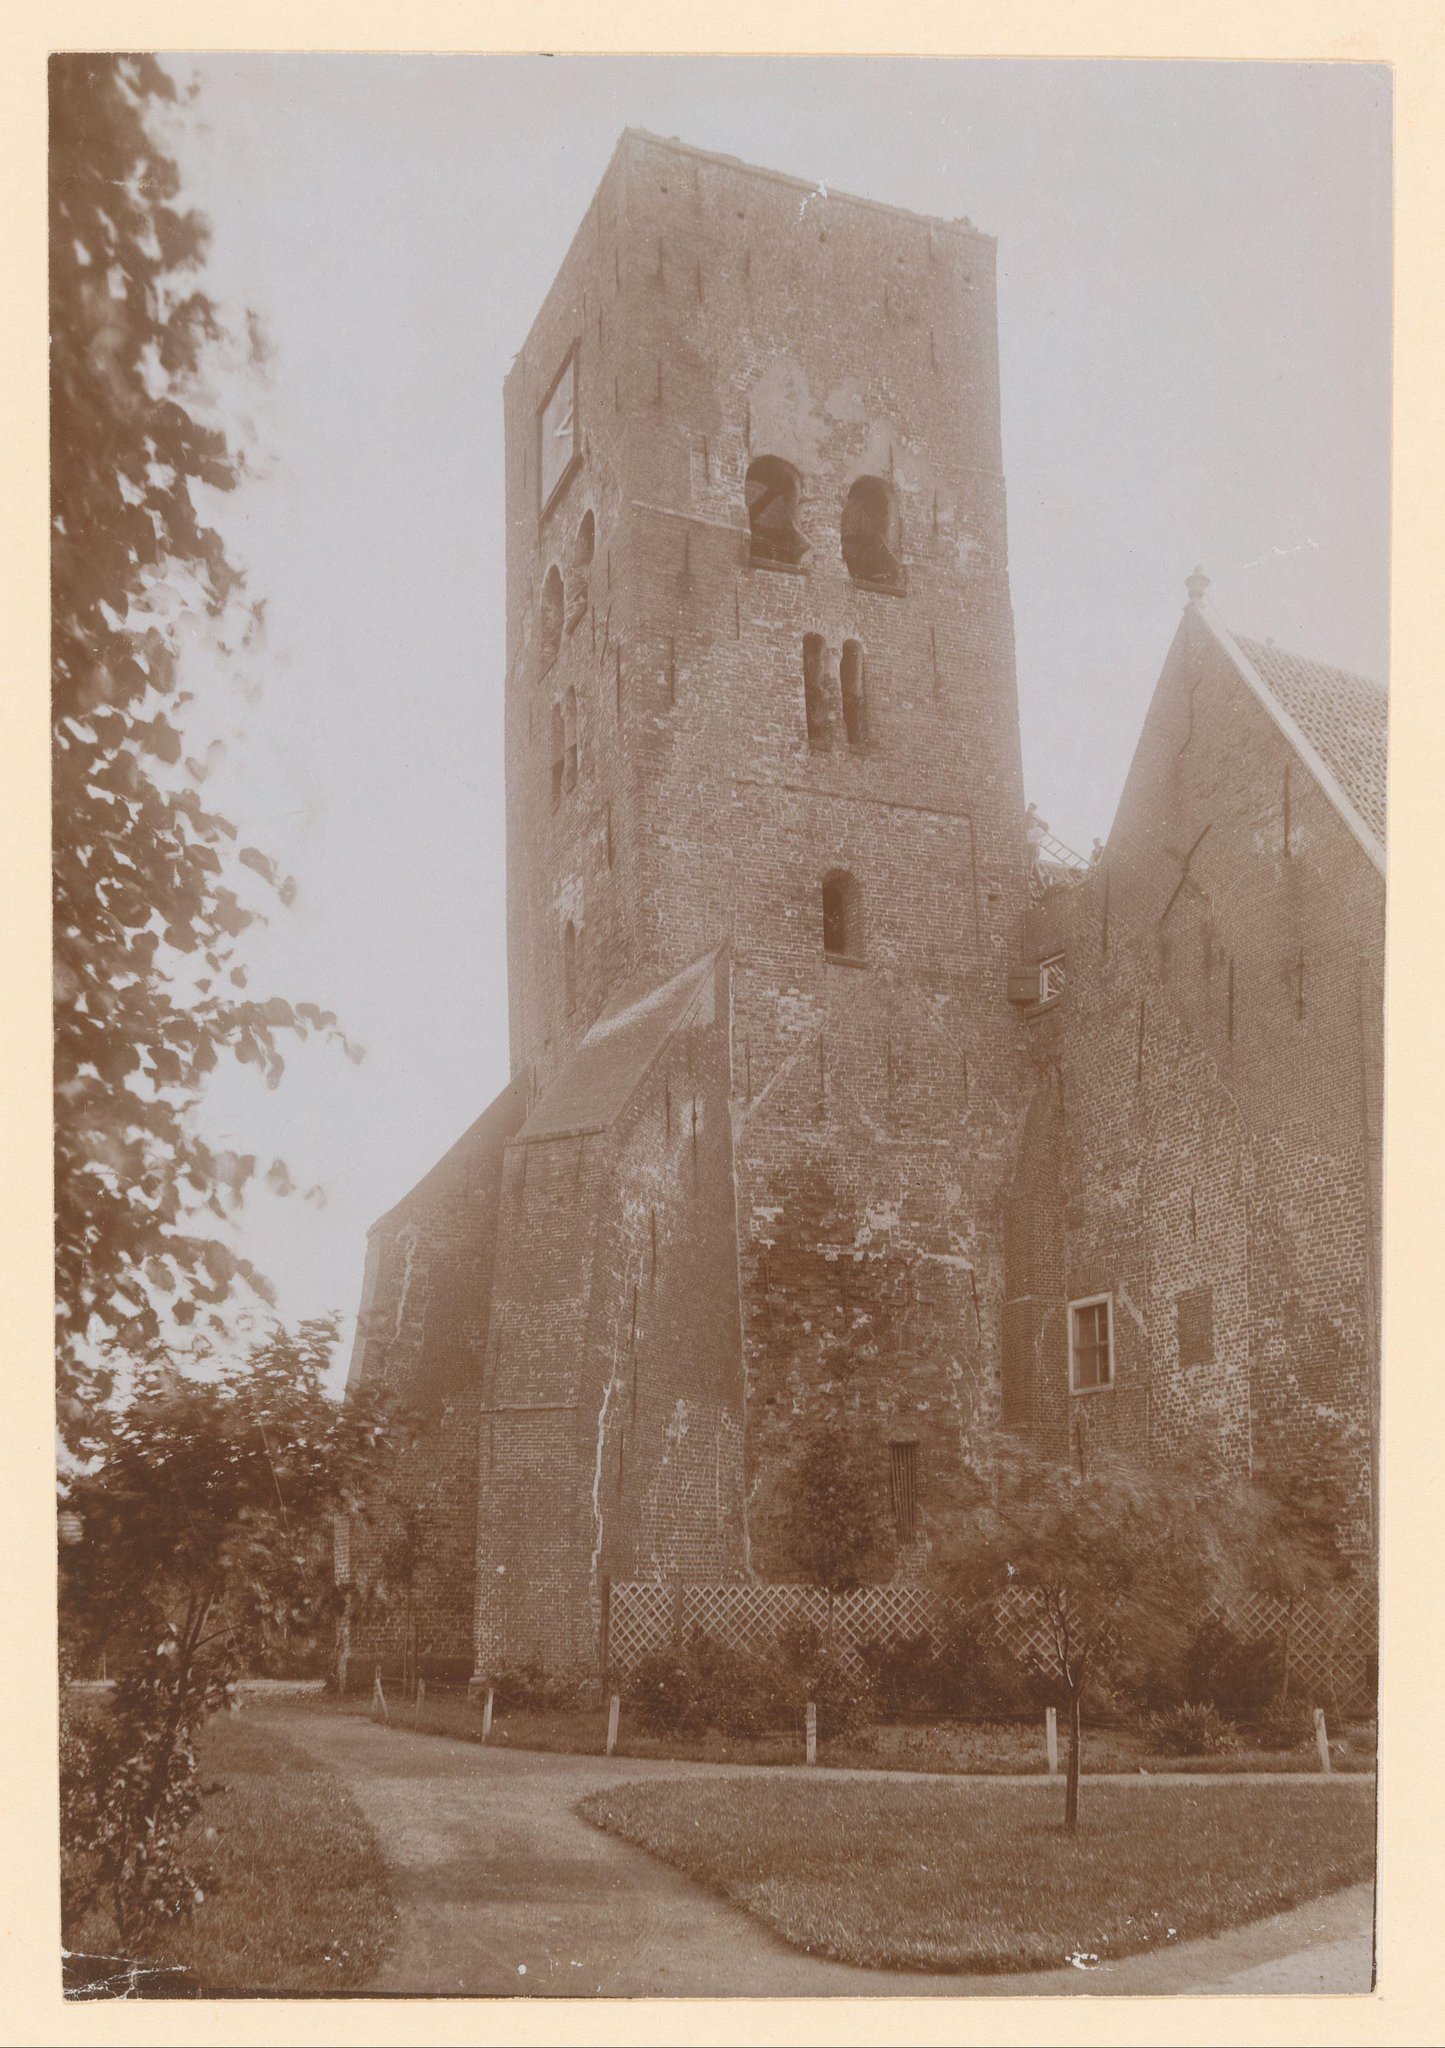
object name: photograph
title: Toren van de Walfriduskerk te Bedum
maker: anoniem (monumentenzorg)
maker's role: fotograaf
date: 1911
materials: cardboard, photographic support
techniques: collodion silver print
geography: bedum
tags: parts of church exterior and annexes: tower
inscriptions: annotation: ‘Juni 1911/ Bedum’